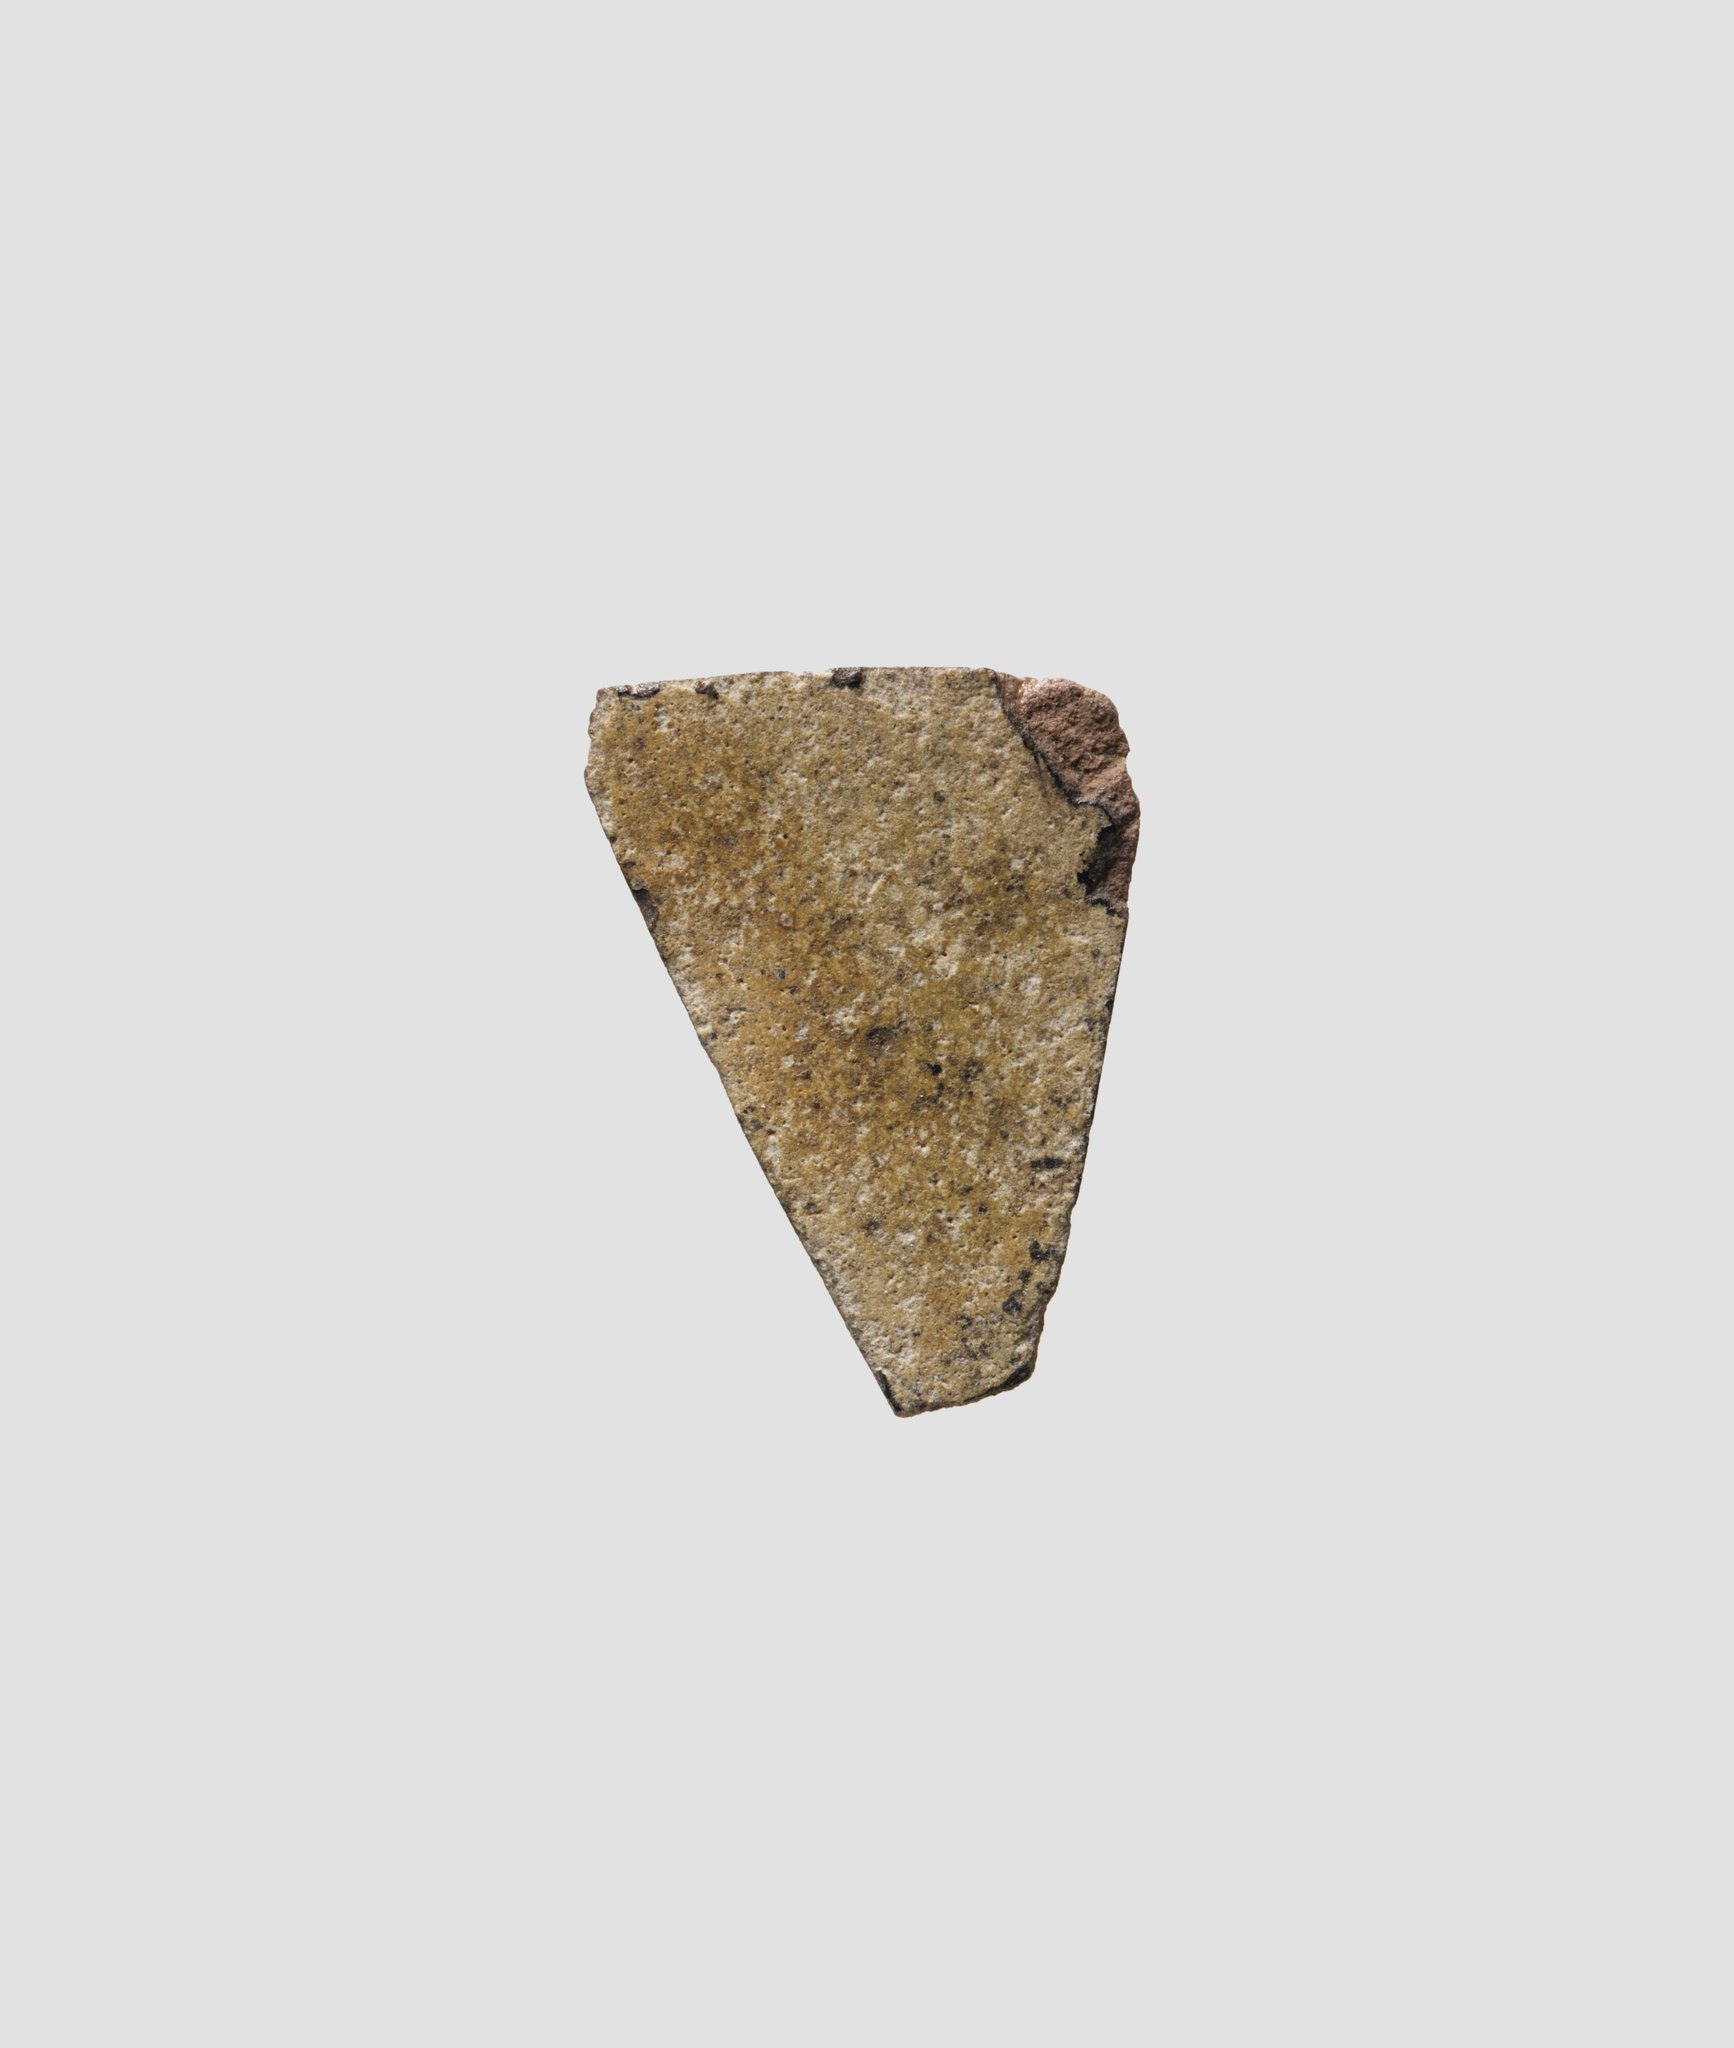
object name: sherd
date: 1300-1101 BCE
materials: ceramic, glaze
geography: syria